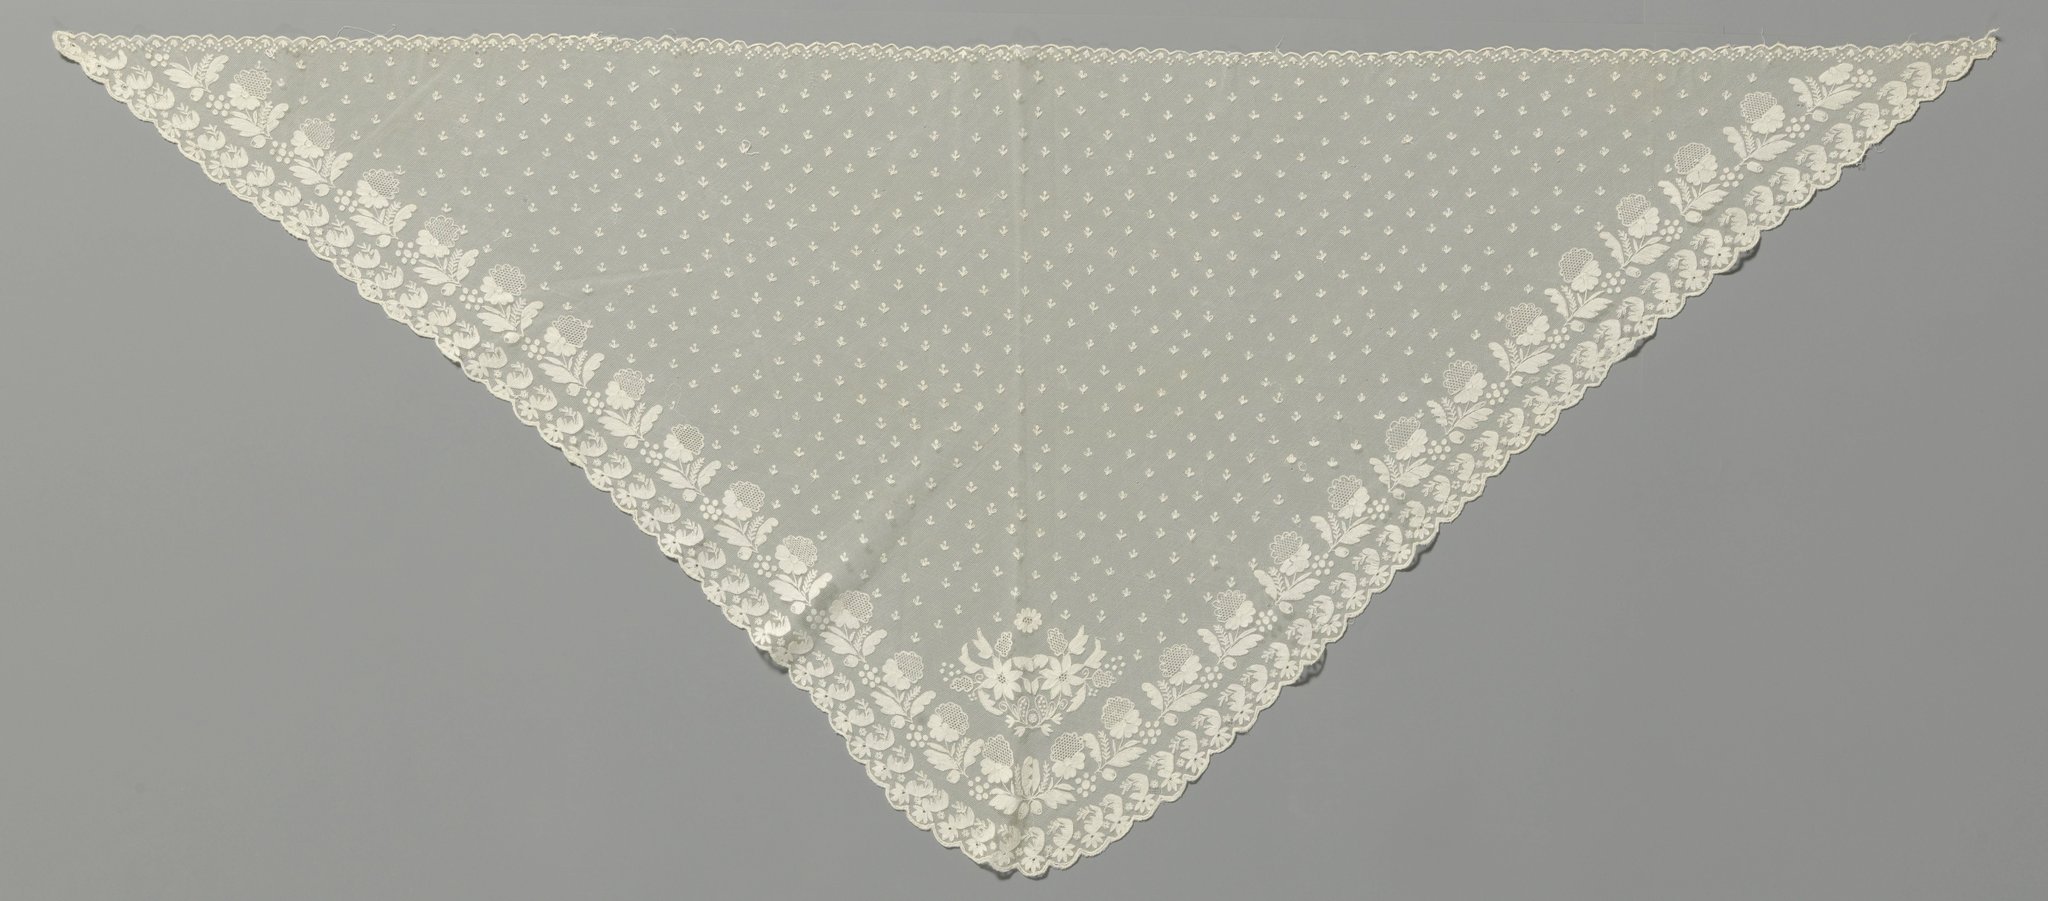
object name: fichu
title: Fichu van machinale kant met tamboereerwerk en naaldkant siervullingen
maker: Anonymous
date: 1830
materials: fiber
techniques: lace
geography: netherlands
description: Fichu van naturelkleurige machinale kant: machinaal tamboereerwerk op machinale tule. Driehoekig model met spitse zijpunten en onderaan een afgeronde punt. De lange zijde tussen de twee spitse punten heeft een fijn schulpenrandje waarlangs een smal patroontje loopt met afwisselend een klein drieblad en vier moesjes. Vanaf hier wordt het middenveld opgevuld met een strooipatroon van twee blaadjes waartussen op een kort steeltje een stipje staat als bloempje. Langs de twee schuine zijden loopt een iets grovere schulpenrand, waarlangs een dubbele rij bloemen, de buitenste rij fijner dan de binnenste rand die bestaat uit licht gebogen viooltakken afgewisseld door rozetten gemaakt met zeven stippen. In de afgeronde punt staat een symmetrische dubbele bloemtak.